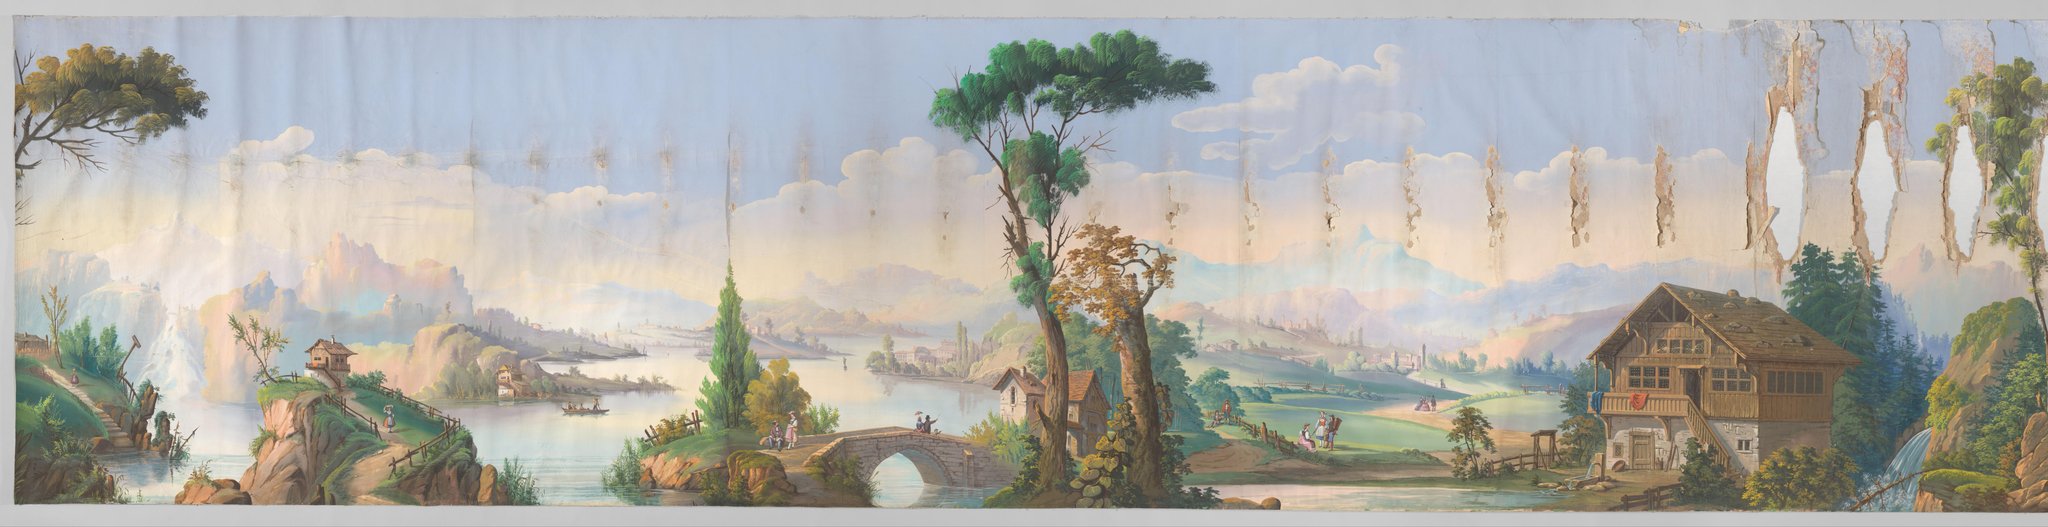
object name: interieuronderdeel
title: Fragment van een bewegend panorama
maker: heinrich heyl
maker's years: 1830-1879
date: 1853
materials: paper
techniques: painted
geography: berlin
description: Fragment van een bewegend panorama met voorstellingen van idyllische landschappen, waar figuren zich op ontspannen manier in bewegen. Deze rol maakt deel uit van een verzameling van zes rollen; enkele rollen hebben repeterende langwerpige verticale vochtvlekken of zelfs gaten. Zie tevens: BK-18283-a/d en f.